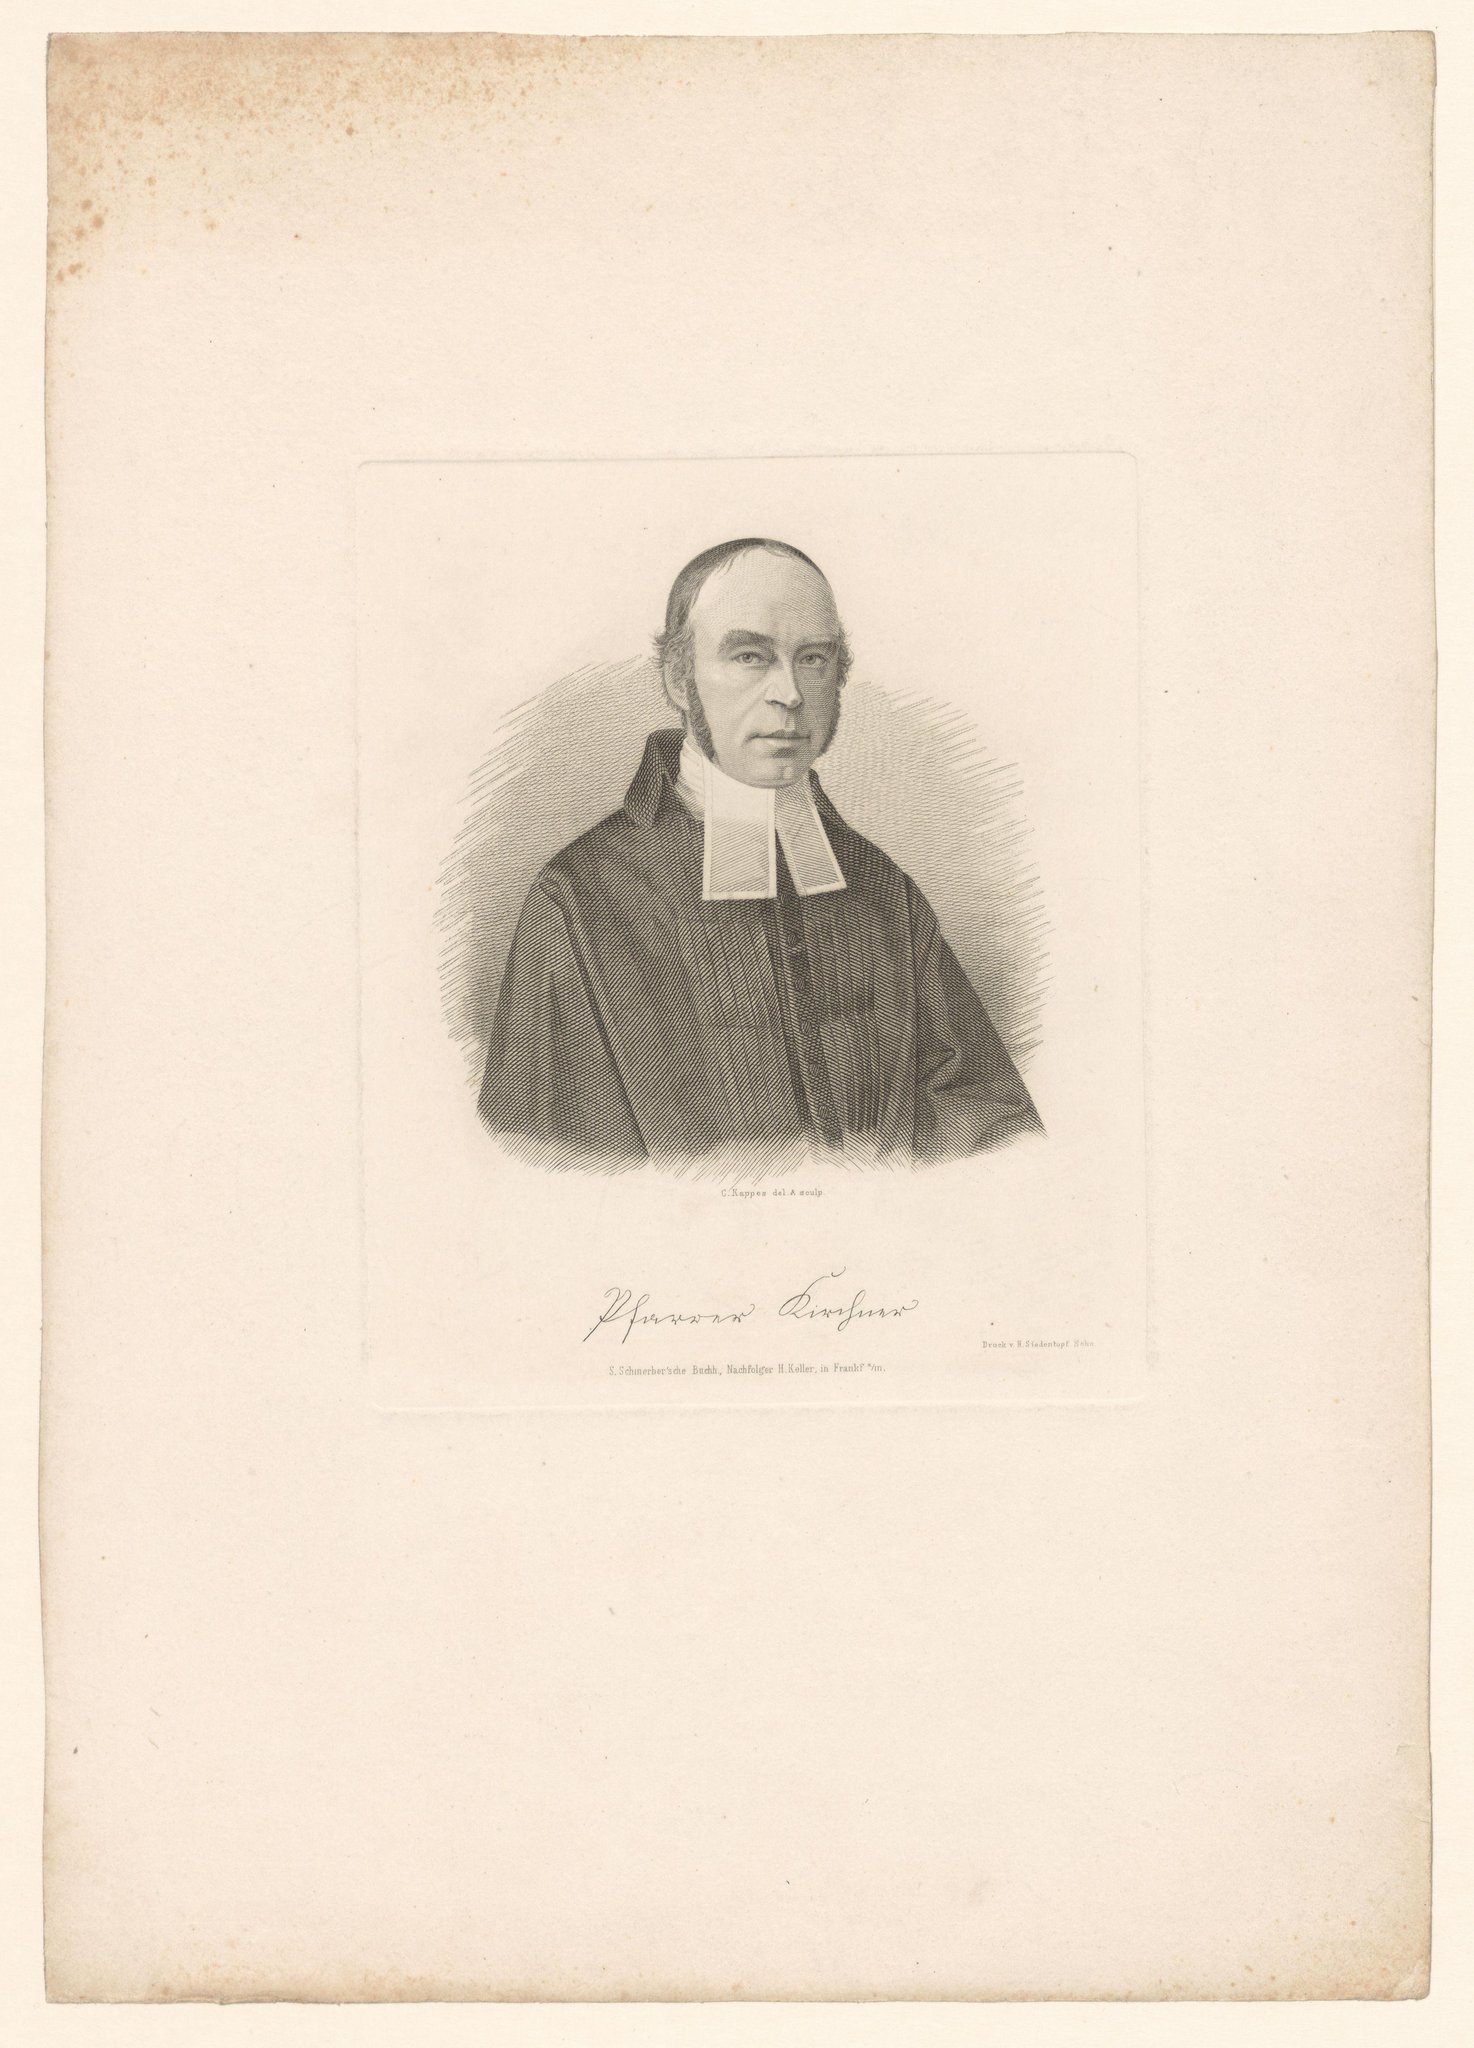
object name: print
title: Portret van Konrad Maximilian Kirchner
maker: karl kappes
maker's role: print maker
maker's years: 1821-1857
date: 1831-1857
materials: paper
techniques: engraving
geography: frankfurt am main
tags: theologian, historical persons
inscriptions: collector's mark: Lugt 2228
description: Onderaan een facsimile signatuur met 'Pfarrer Kirchner' in Sütterlin handschrift.